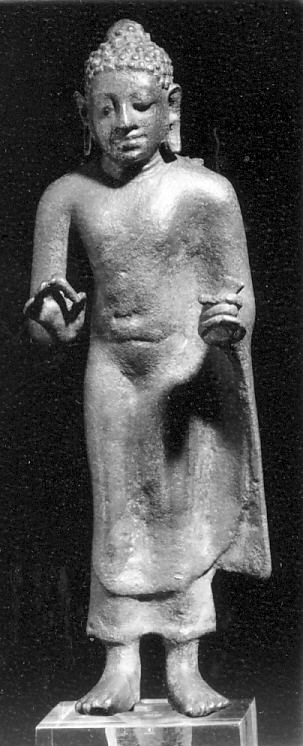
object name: figure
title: Standing Buddha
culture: indonesian, javanese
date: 801-850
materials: bronze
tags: buddhism,buddha